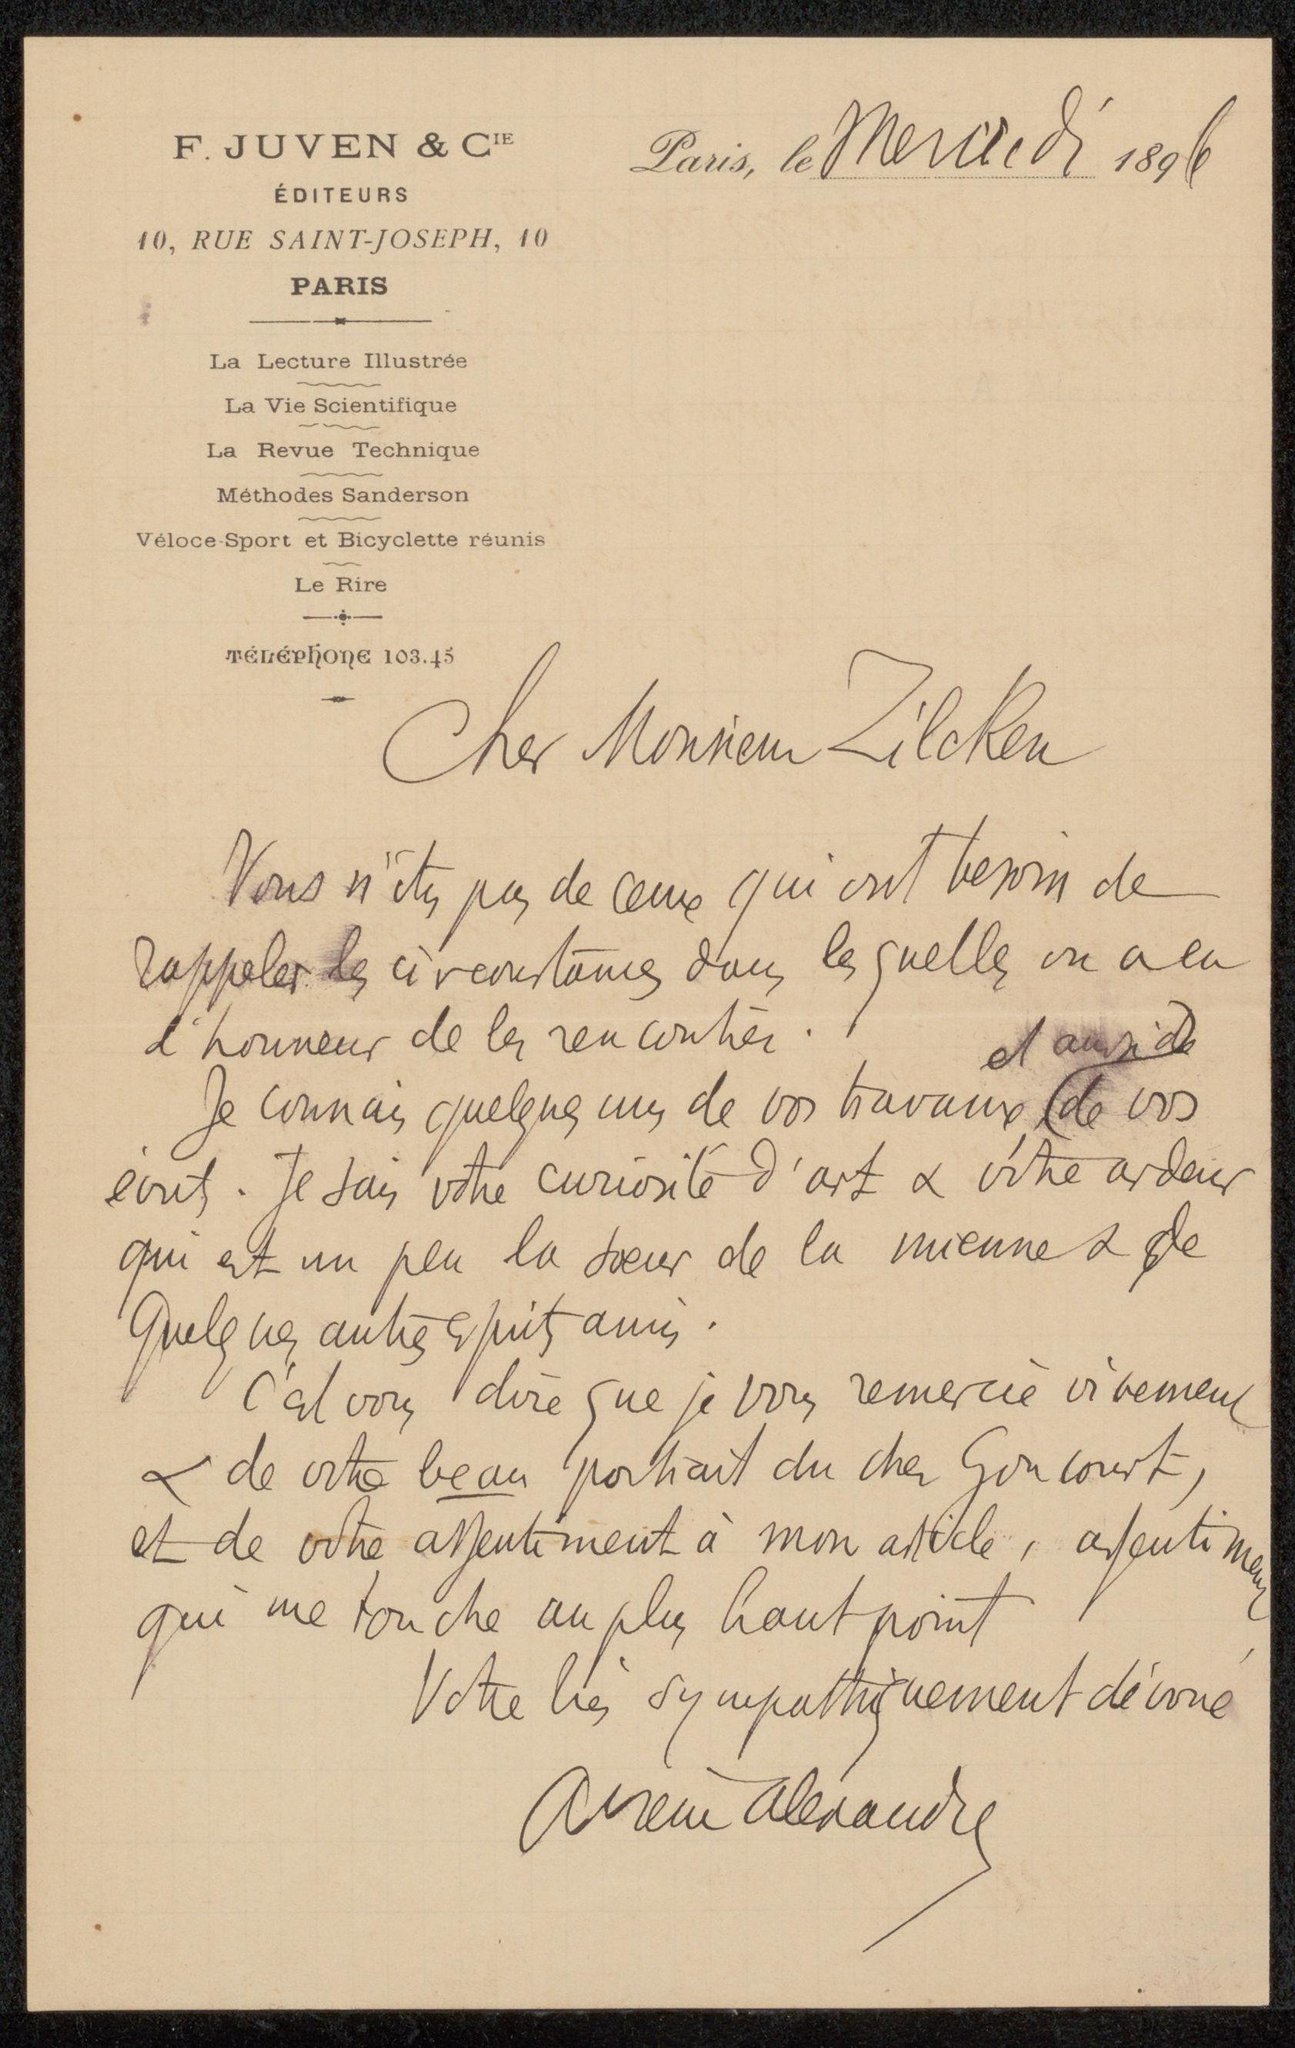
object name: letter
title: Brief aan Philip Zilcken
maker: arsène alexandre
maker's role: auteur, verzamelaar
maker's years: 1859-1937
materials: ink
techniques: pen, printing, writing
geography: paris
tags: edmond de goncourt, painter, draughtsman, philip zilcken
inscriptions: collector's mark: ‘RPK’